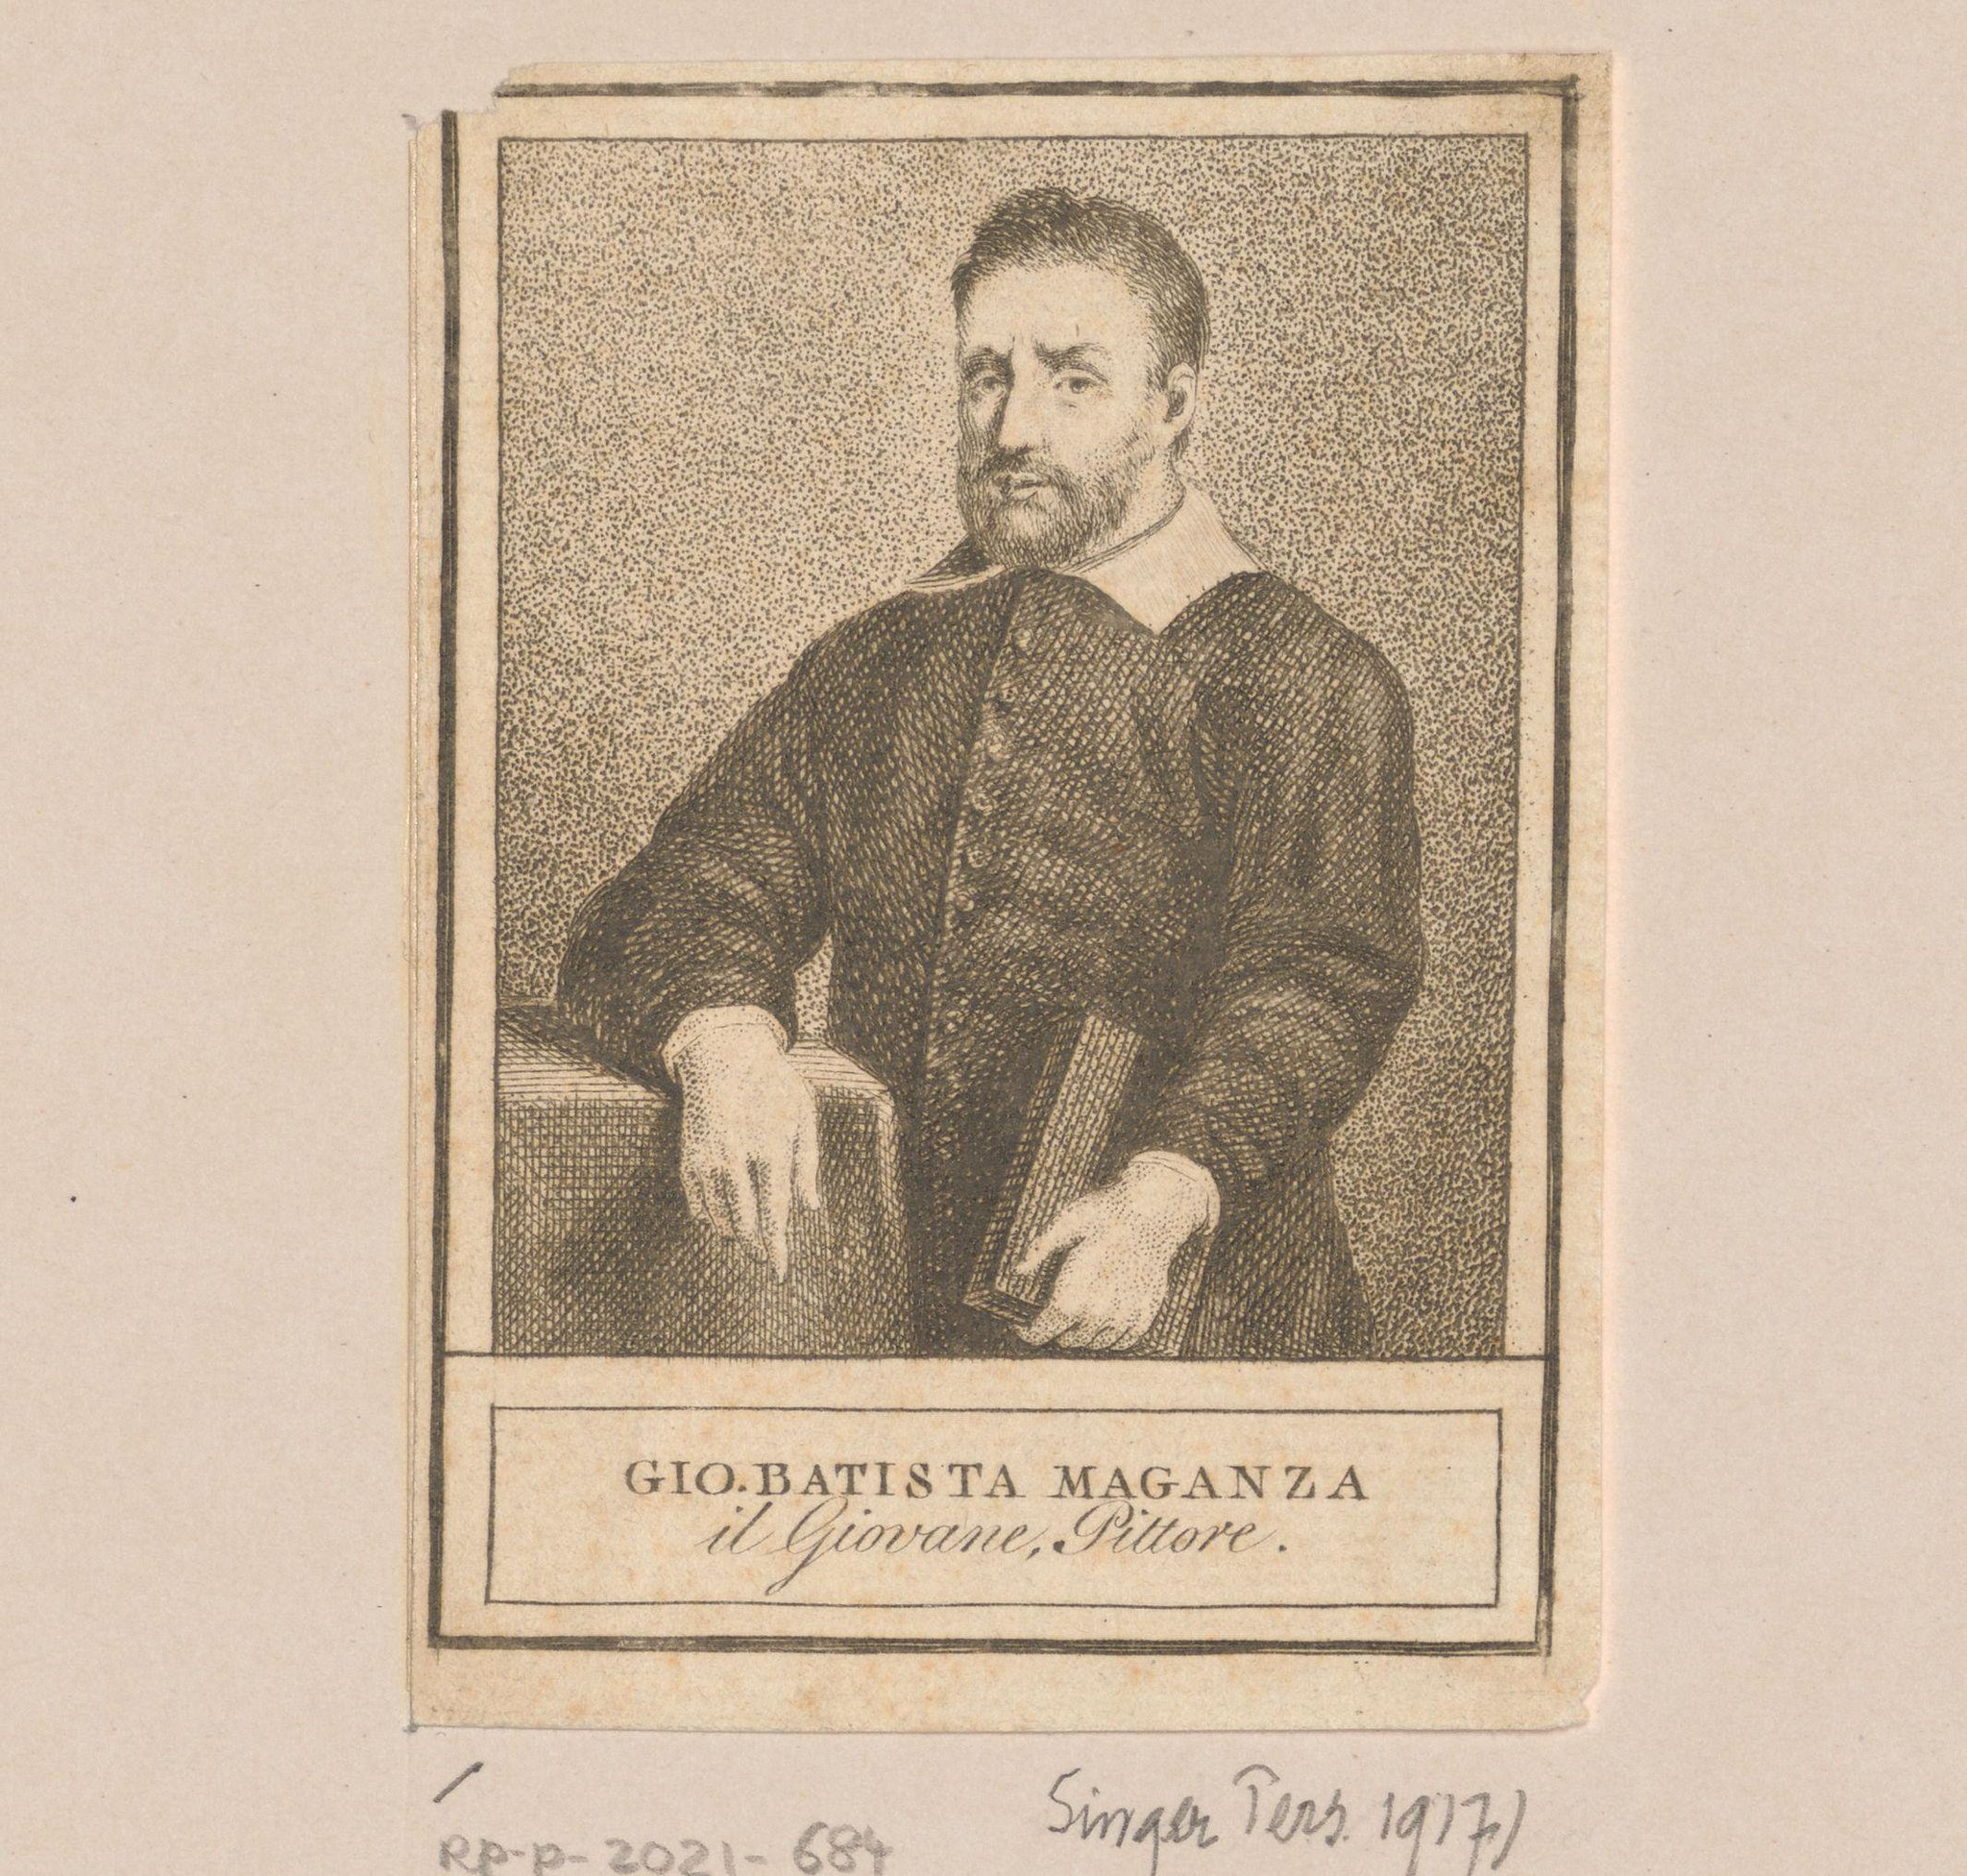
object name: print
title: Portret van Giovanni Battista (II) Maganza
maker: Anonymous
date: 1700-1800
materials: paper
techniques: etching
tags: painter, giovanni battista maganza (ii), historical persons, portrait, self-portrait of painter